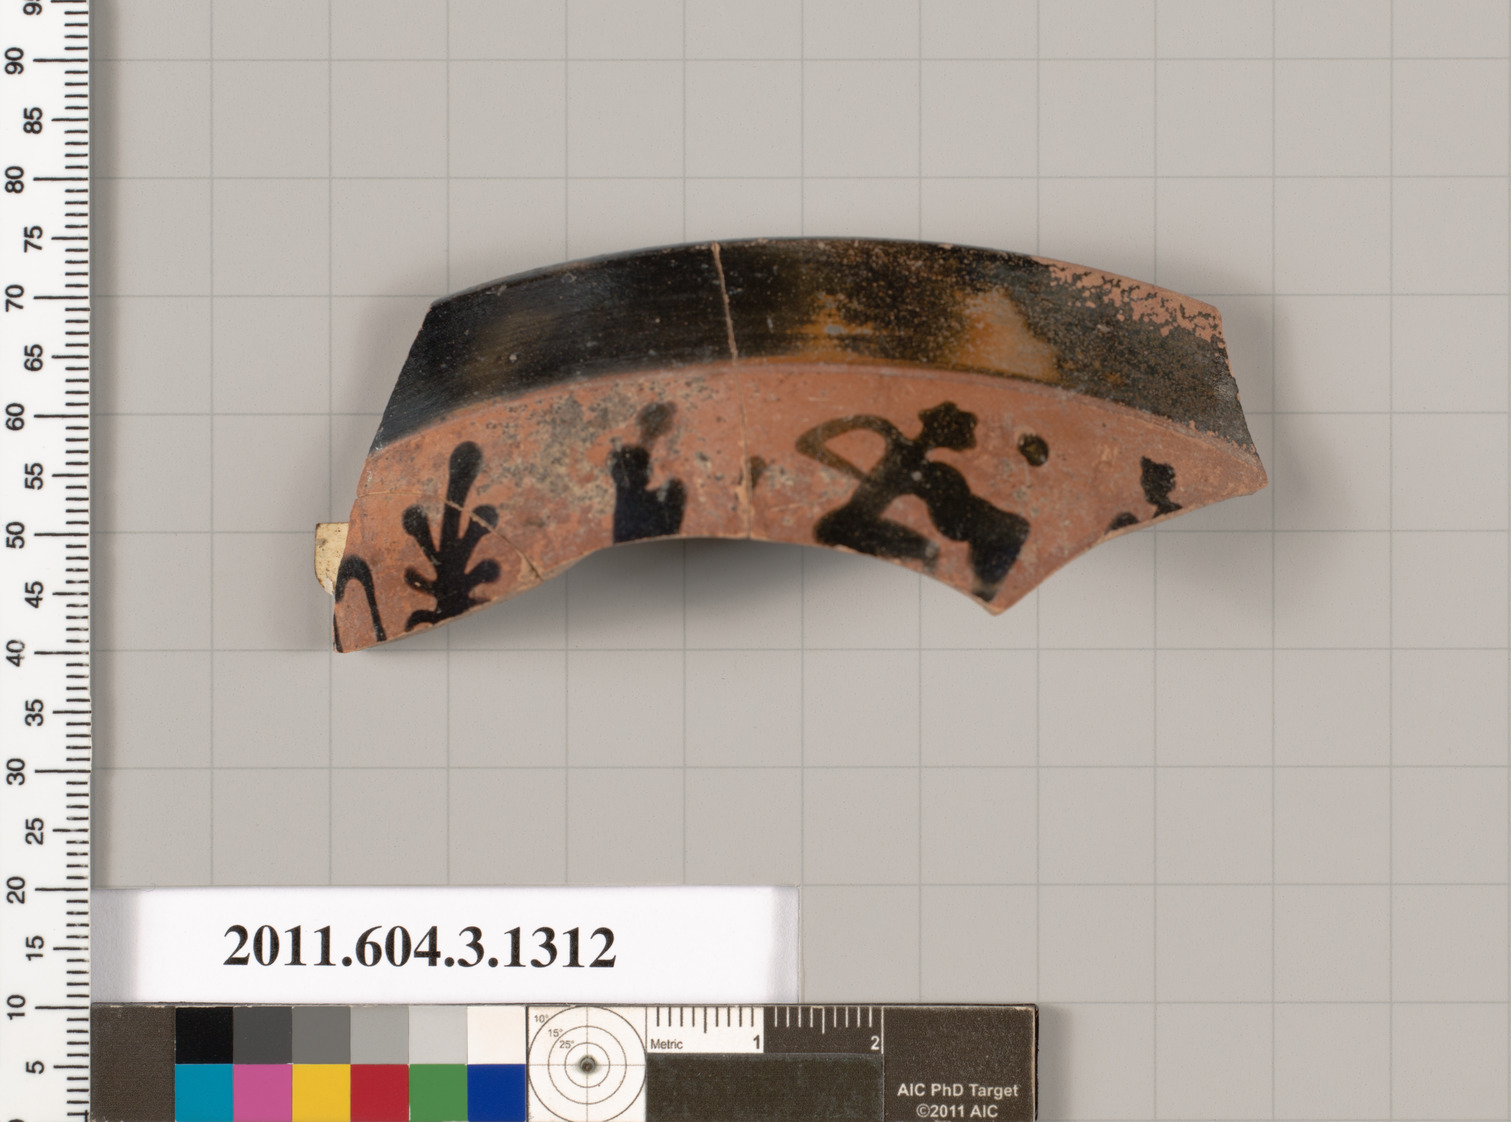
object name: skyphos fragment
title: Terracotta rim fragment of a skyphos (deep drinking cup)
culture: greek, attic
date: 490-480 BCE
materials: terracotta